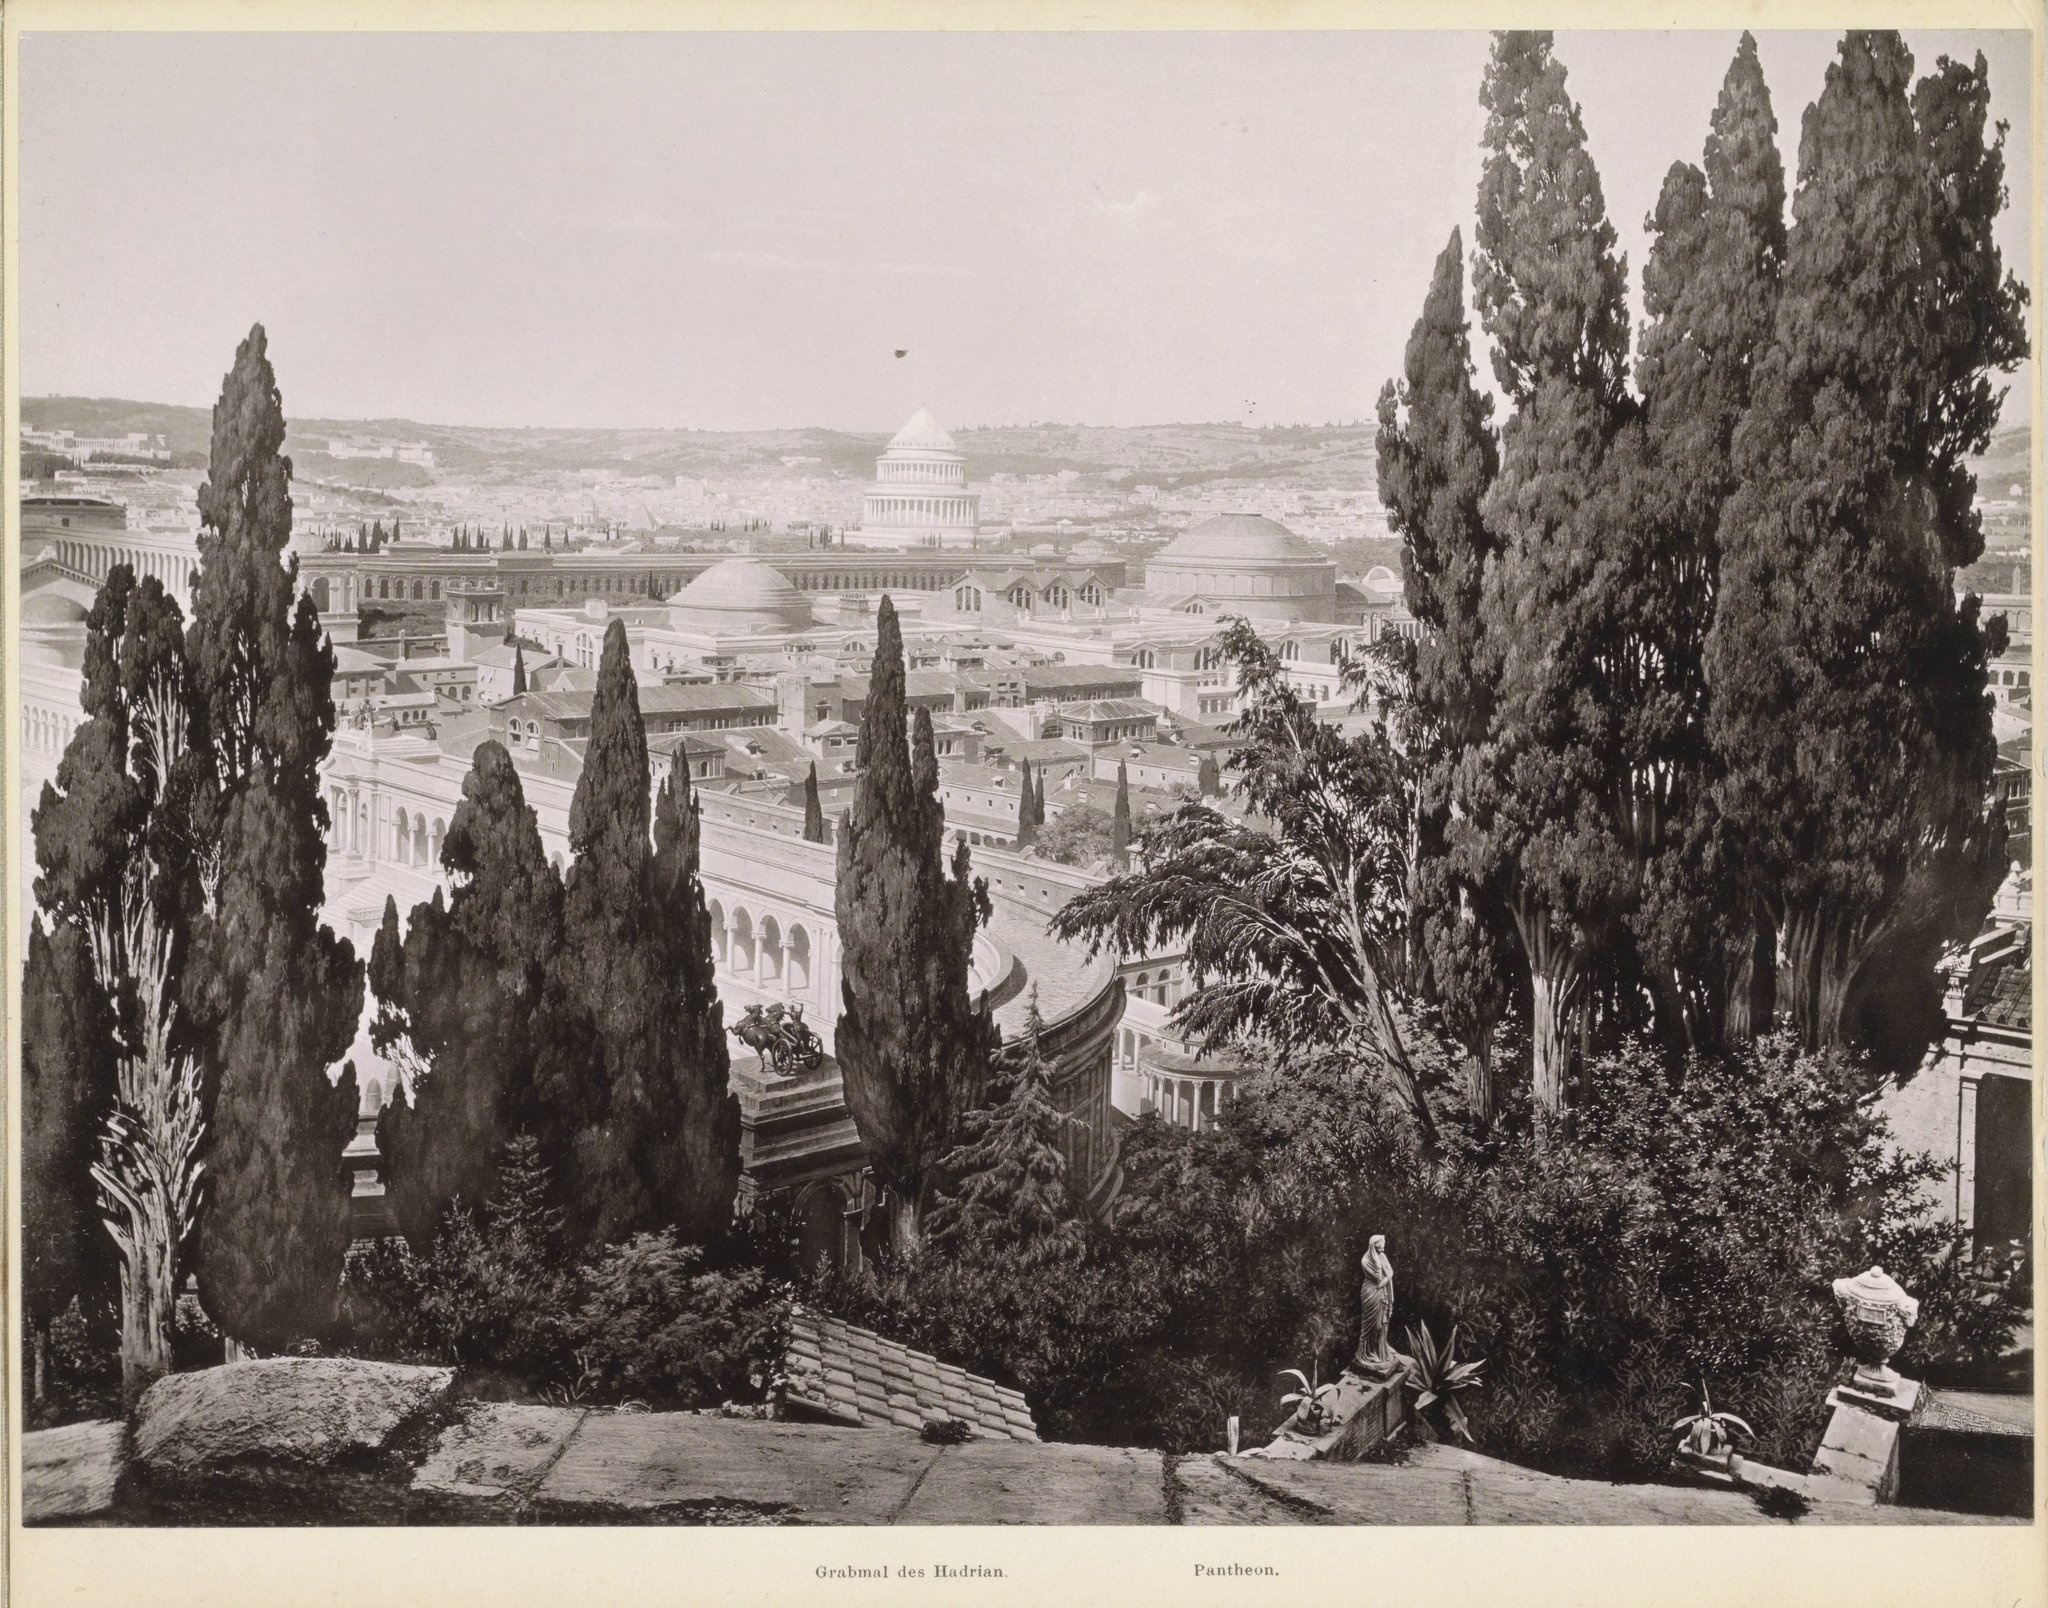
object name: page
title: Grabmal des Hadrian. - Pantheon.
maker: franz seraph hanfstaengl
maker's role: painter, print maker, printer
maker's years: 1804-1877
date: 1890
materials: cardboard, paper, ink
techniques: photograph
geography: munich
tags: mausoleum, temple, shrine ~ roman religion, exterior ~ representation of a building, prospect of city, town panorama, silhouette of city, rome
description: Onderdeel van Panorama van het oude Rome.